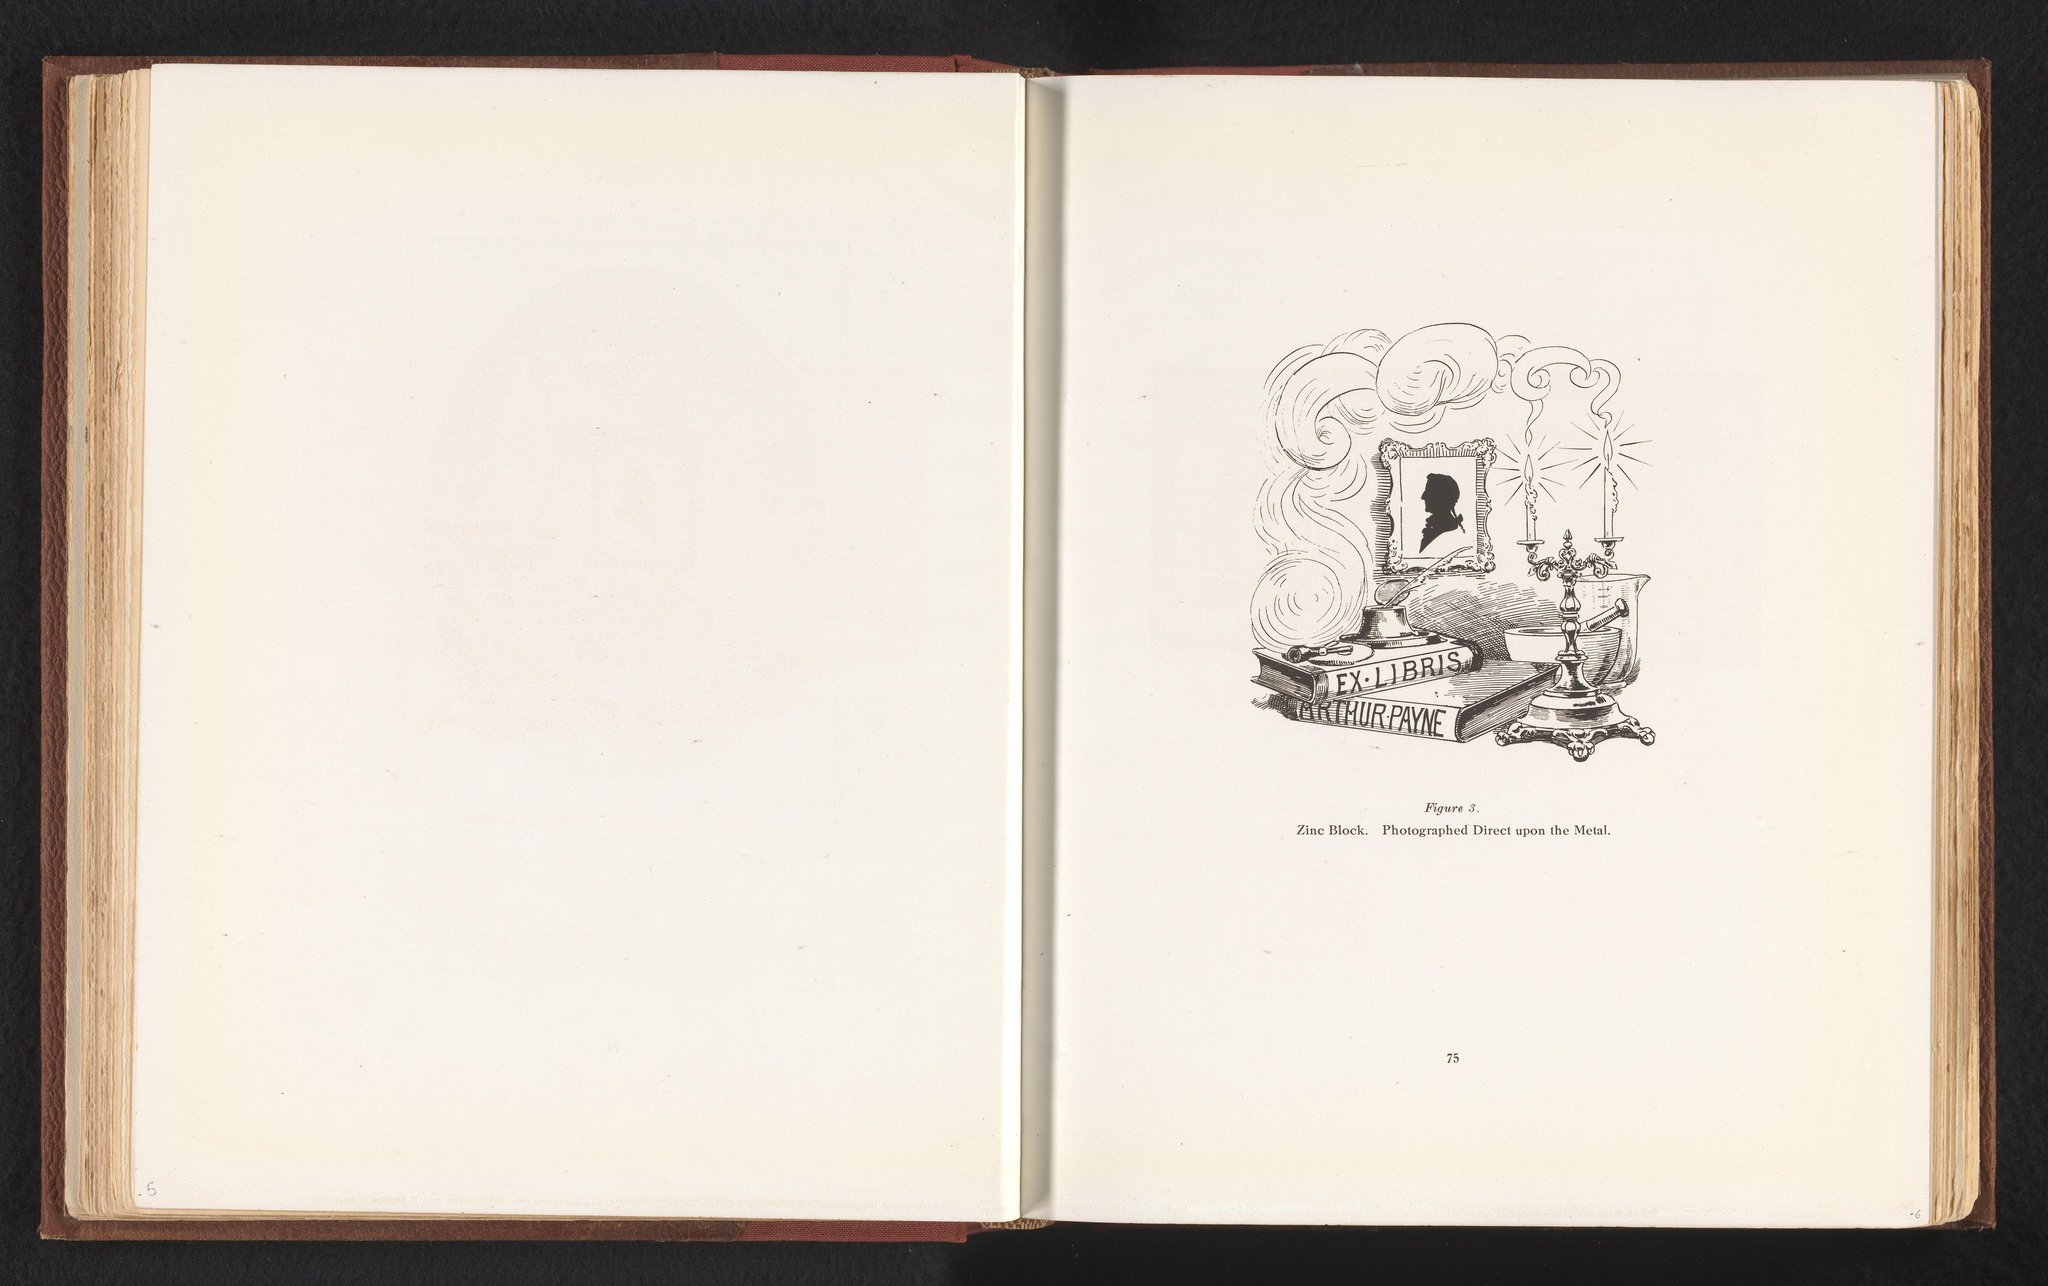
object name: reproduction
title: Reproductie van een ex libris van Arhur Payne, uitvinder van het 'New Direct Process' fotomechanische drukprocedé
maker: arthur payne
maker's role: fotograaf, uitvinder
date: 1904-1909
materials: paper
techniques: photomechanical relief printing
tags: arthur payne, ex-libris